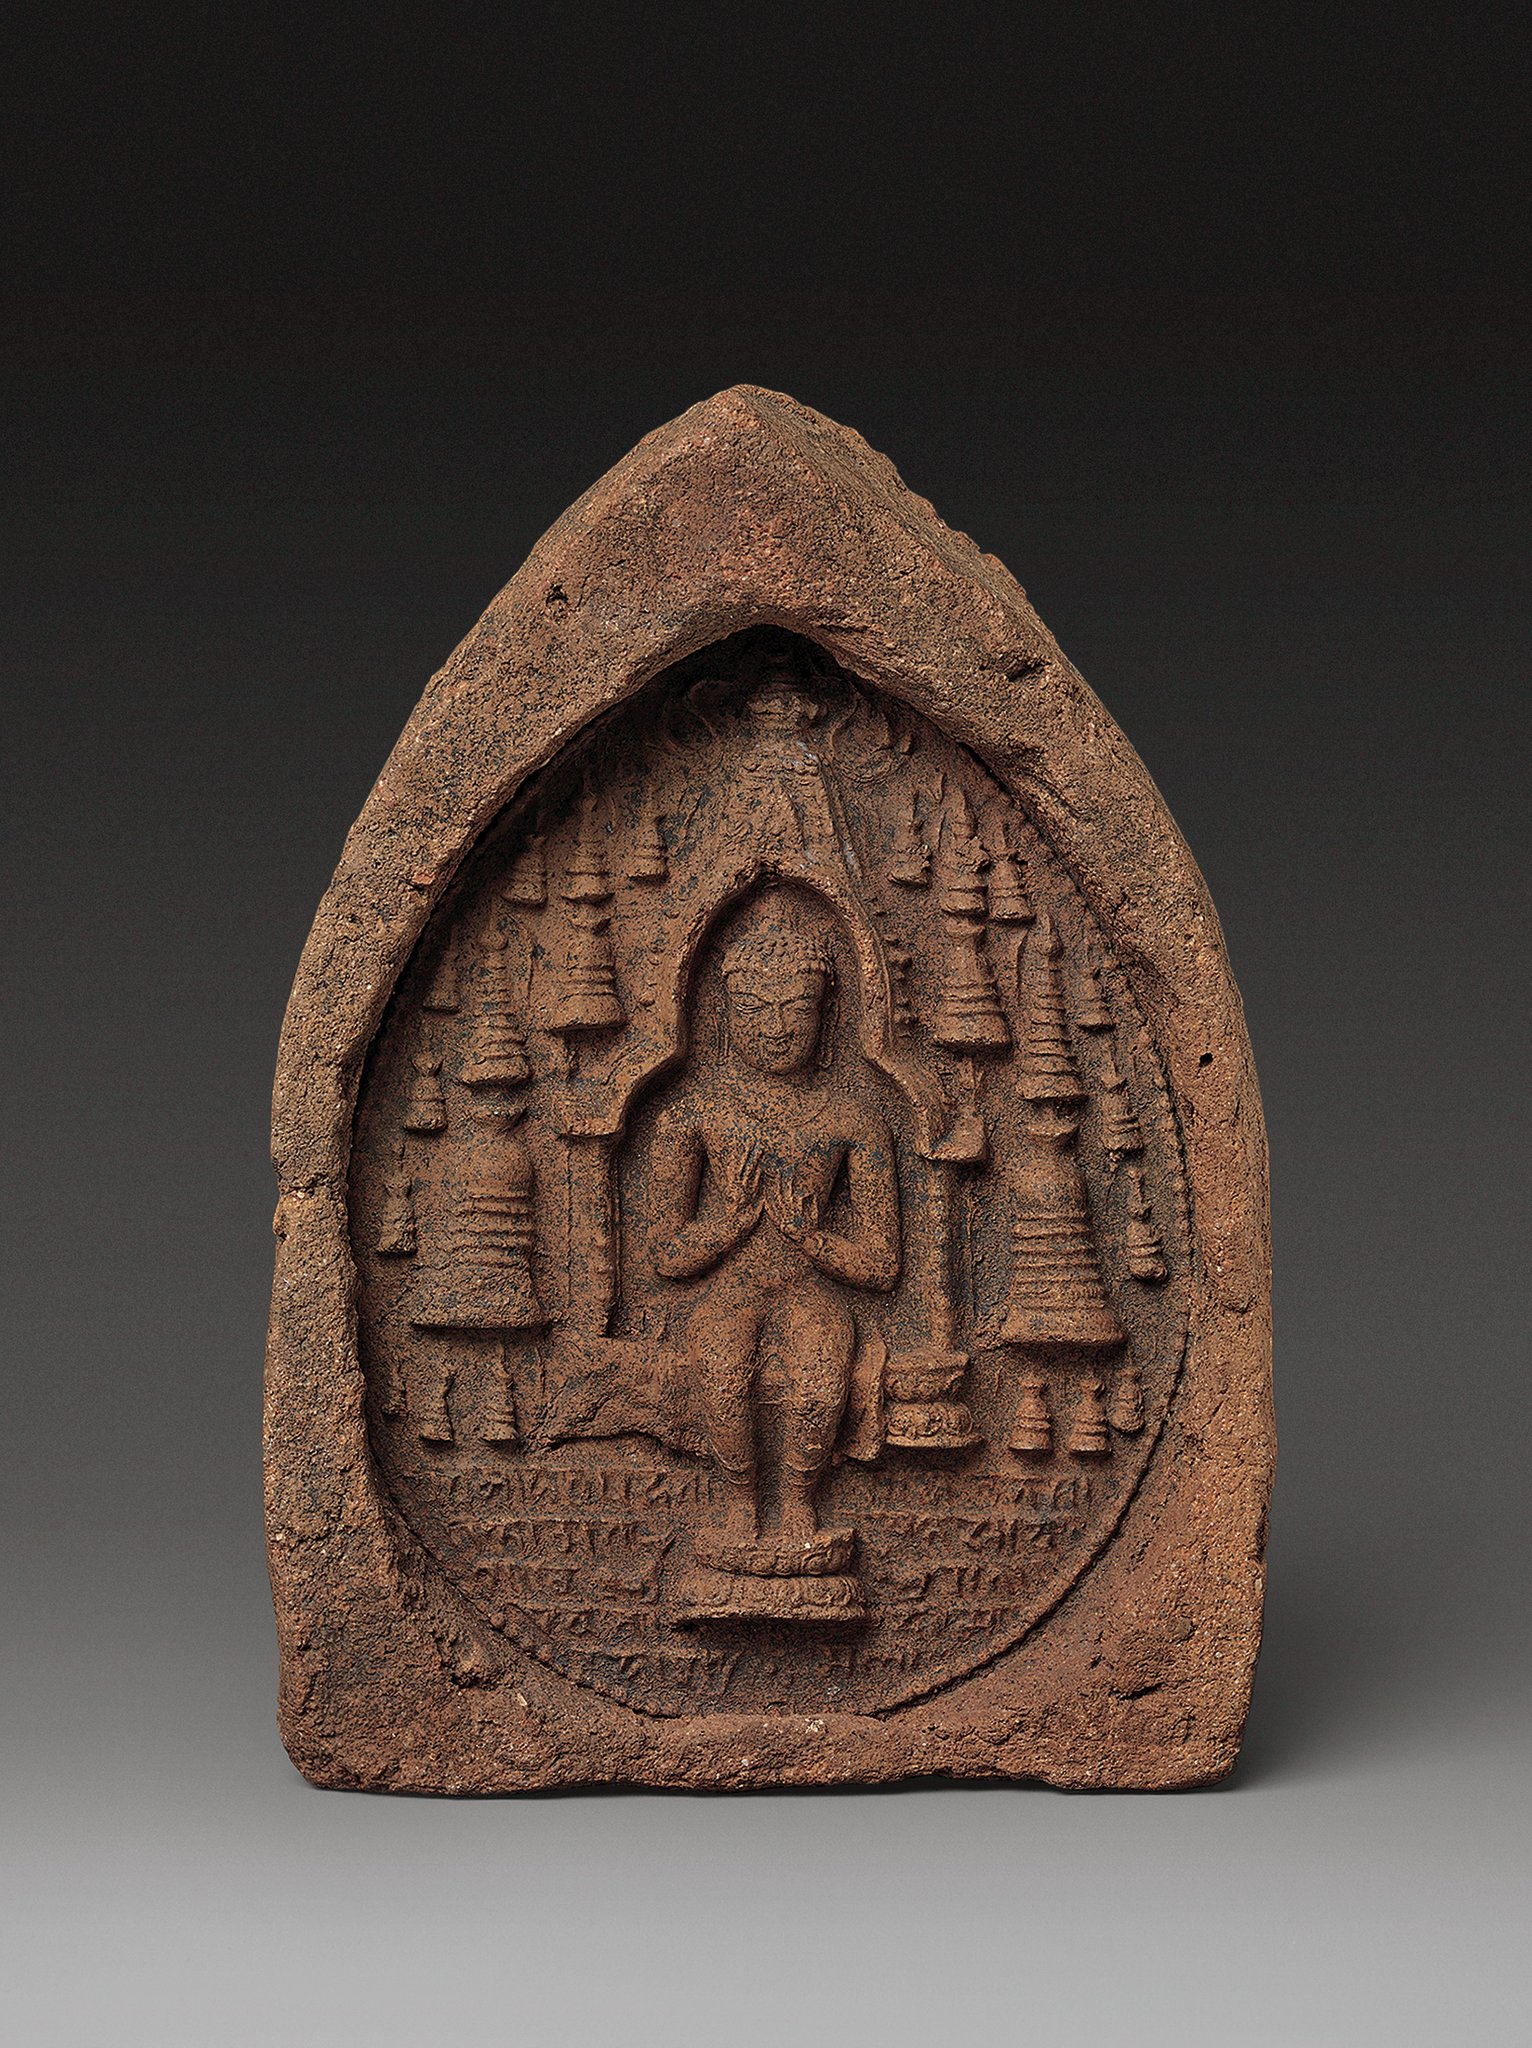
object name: votive plaque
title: Votive Plaque: Seated Buddha in a Temple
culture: indian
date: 801-1000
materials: terracotta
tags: buddhism,buddha